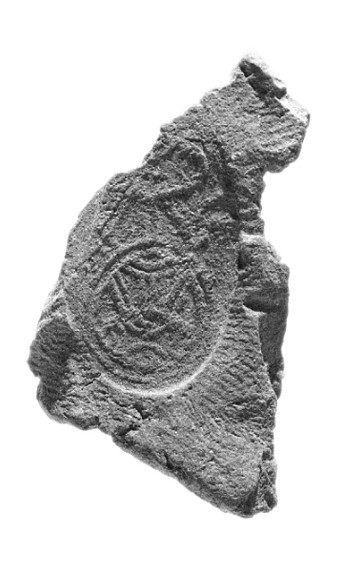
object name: sealing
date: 1981-1640 BCE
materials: mud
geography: egypt